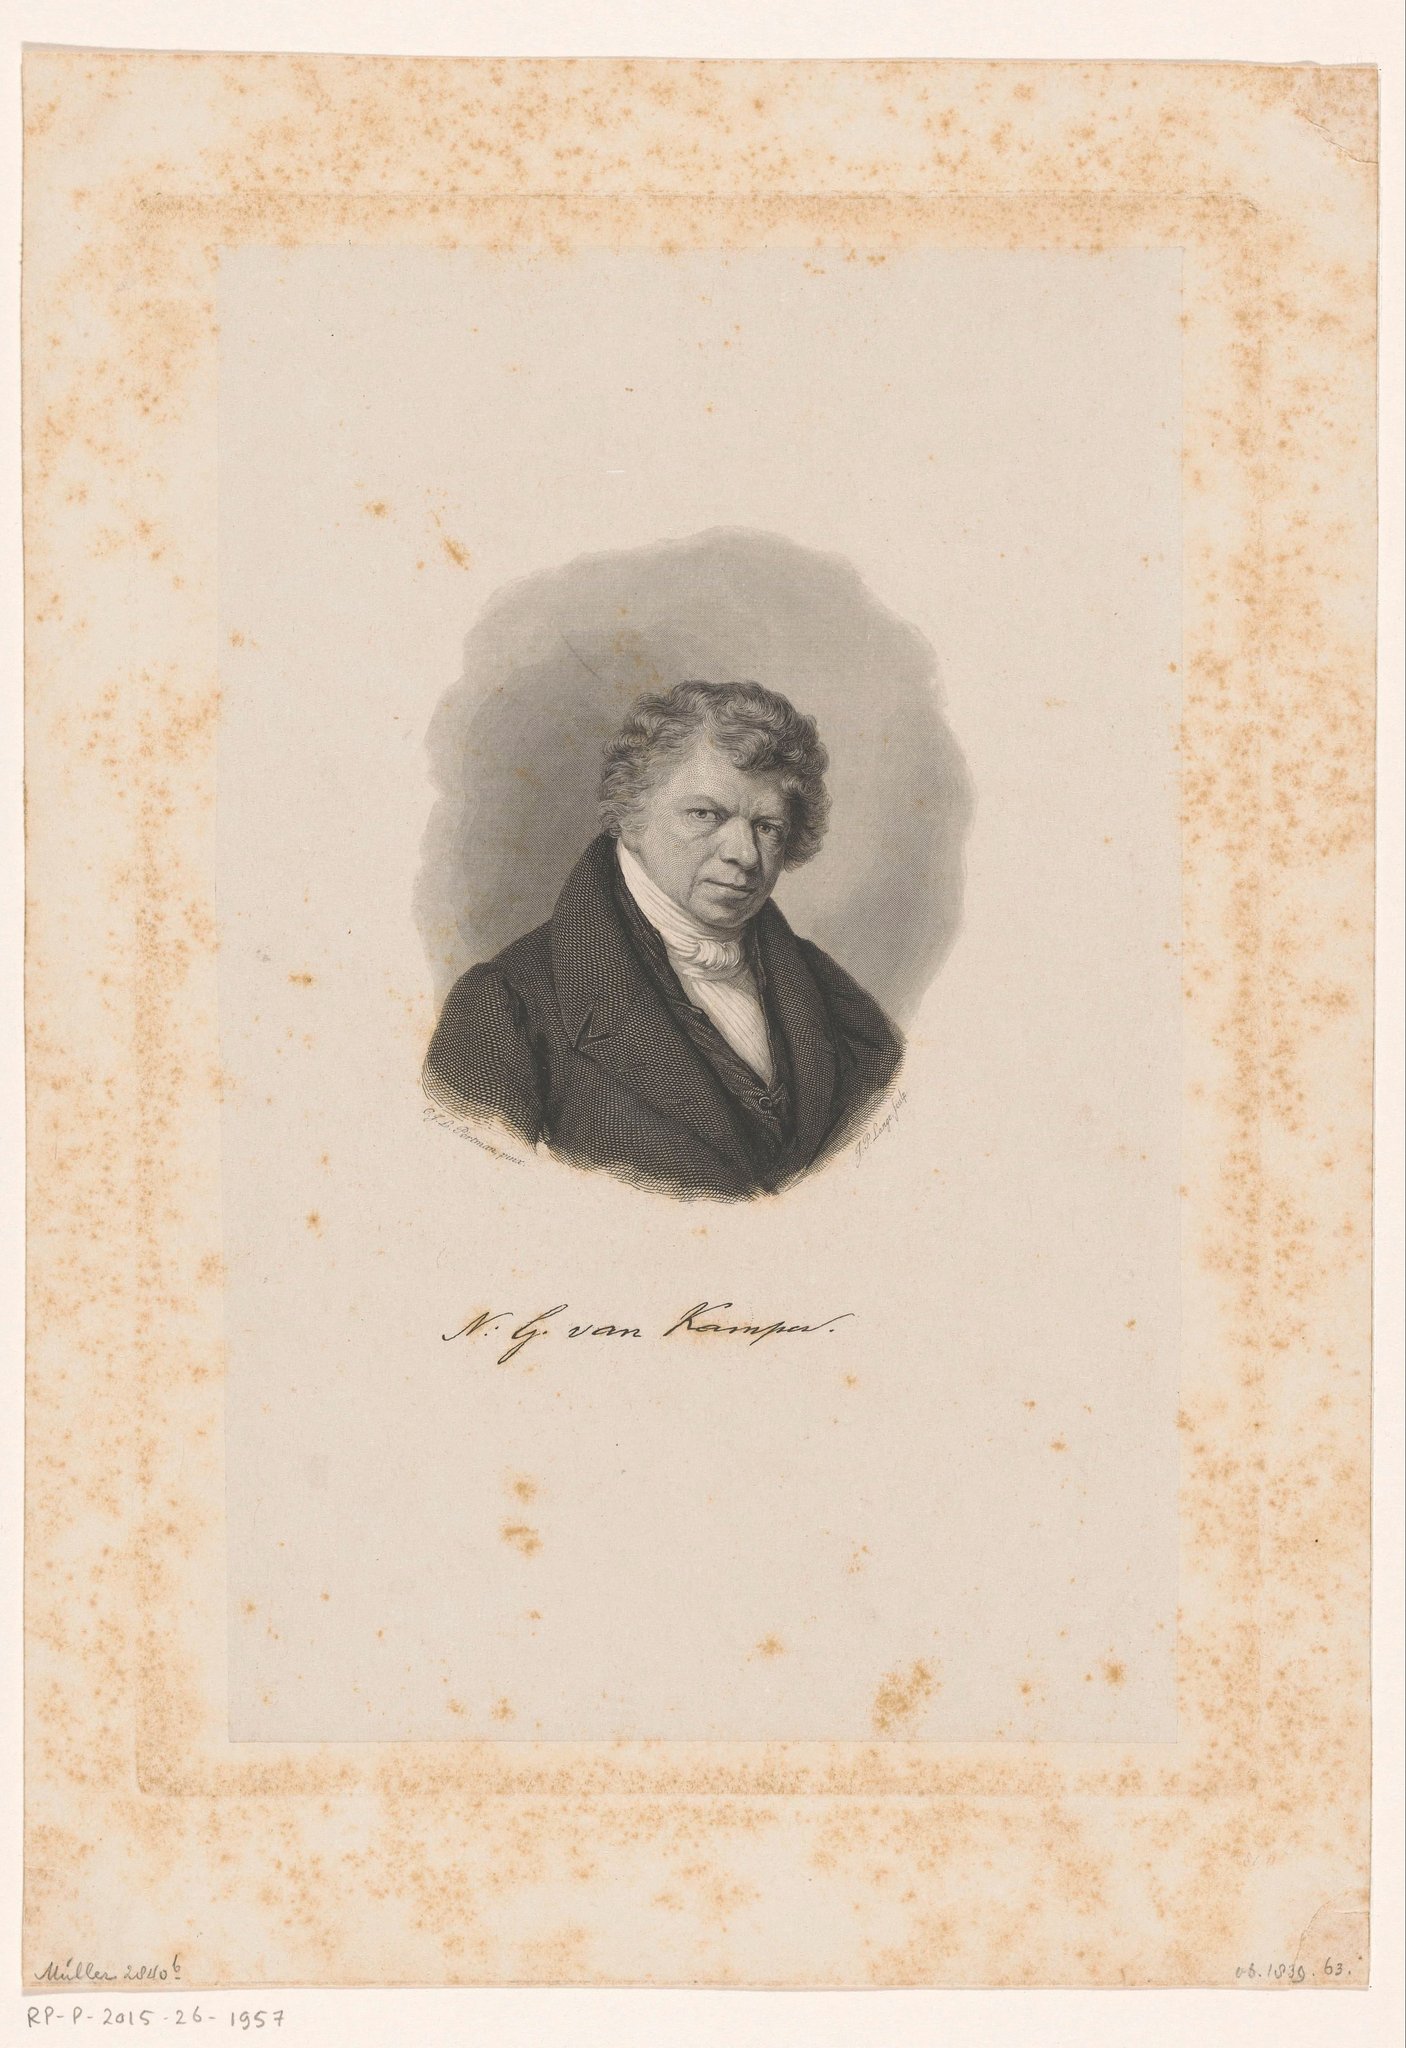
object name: print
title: N.G. van Kampen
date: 1820-1849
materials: paper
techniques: engraving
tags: haarlem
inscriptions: collector's mark: Lugt 2228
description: Portretbuste van Nicolaas Godfried van Kampen, hoogleraar geschiedenis te Amsterdam. Onder het portret zijn signatuur.